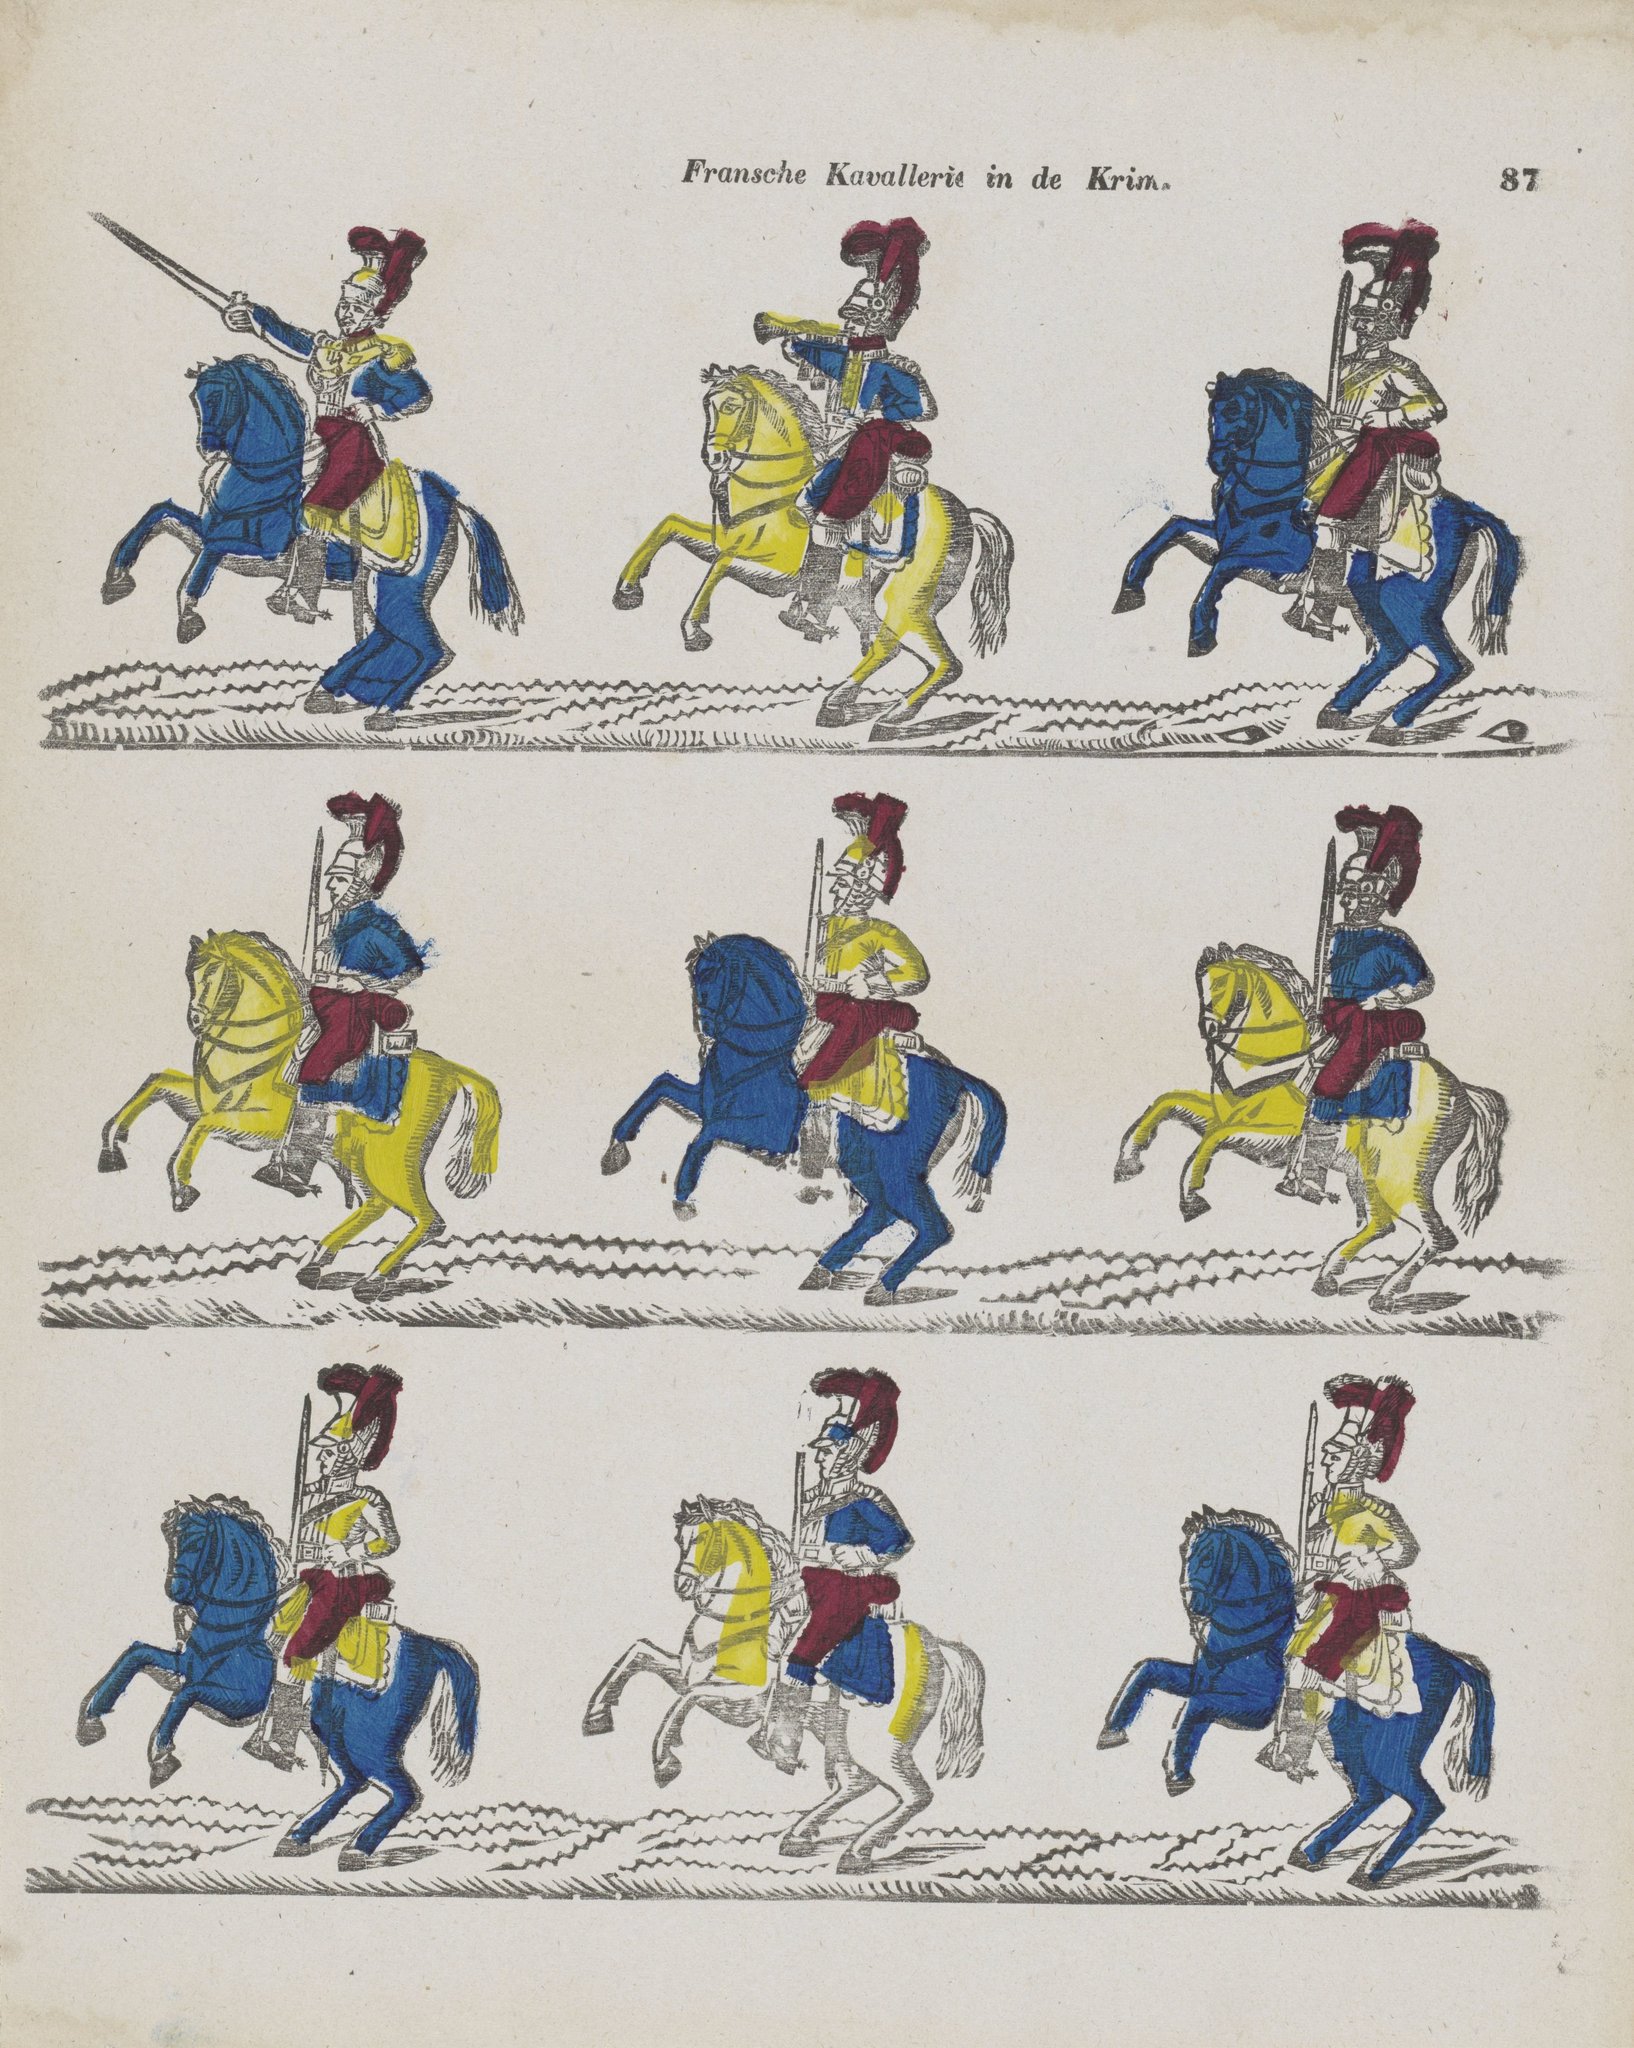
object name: print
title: Fransche kavallerie in de Krim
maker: Anonymous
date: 1848-1881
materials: paper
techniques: colour, letterpress printing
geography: netherlands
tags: warfare; military affairs (+ cavalry, horsemen), the soldier; the soldier's life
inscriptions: collector's mark: Lugt 2760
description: Blad met 9 voorstellingen van Franse militairen te paard. Genummerd rechtsboven: 87.